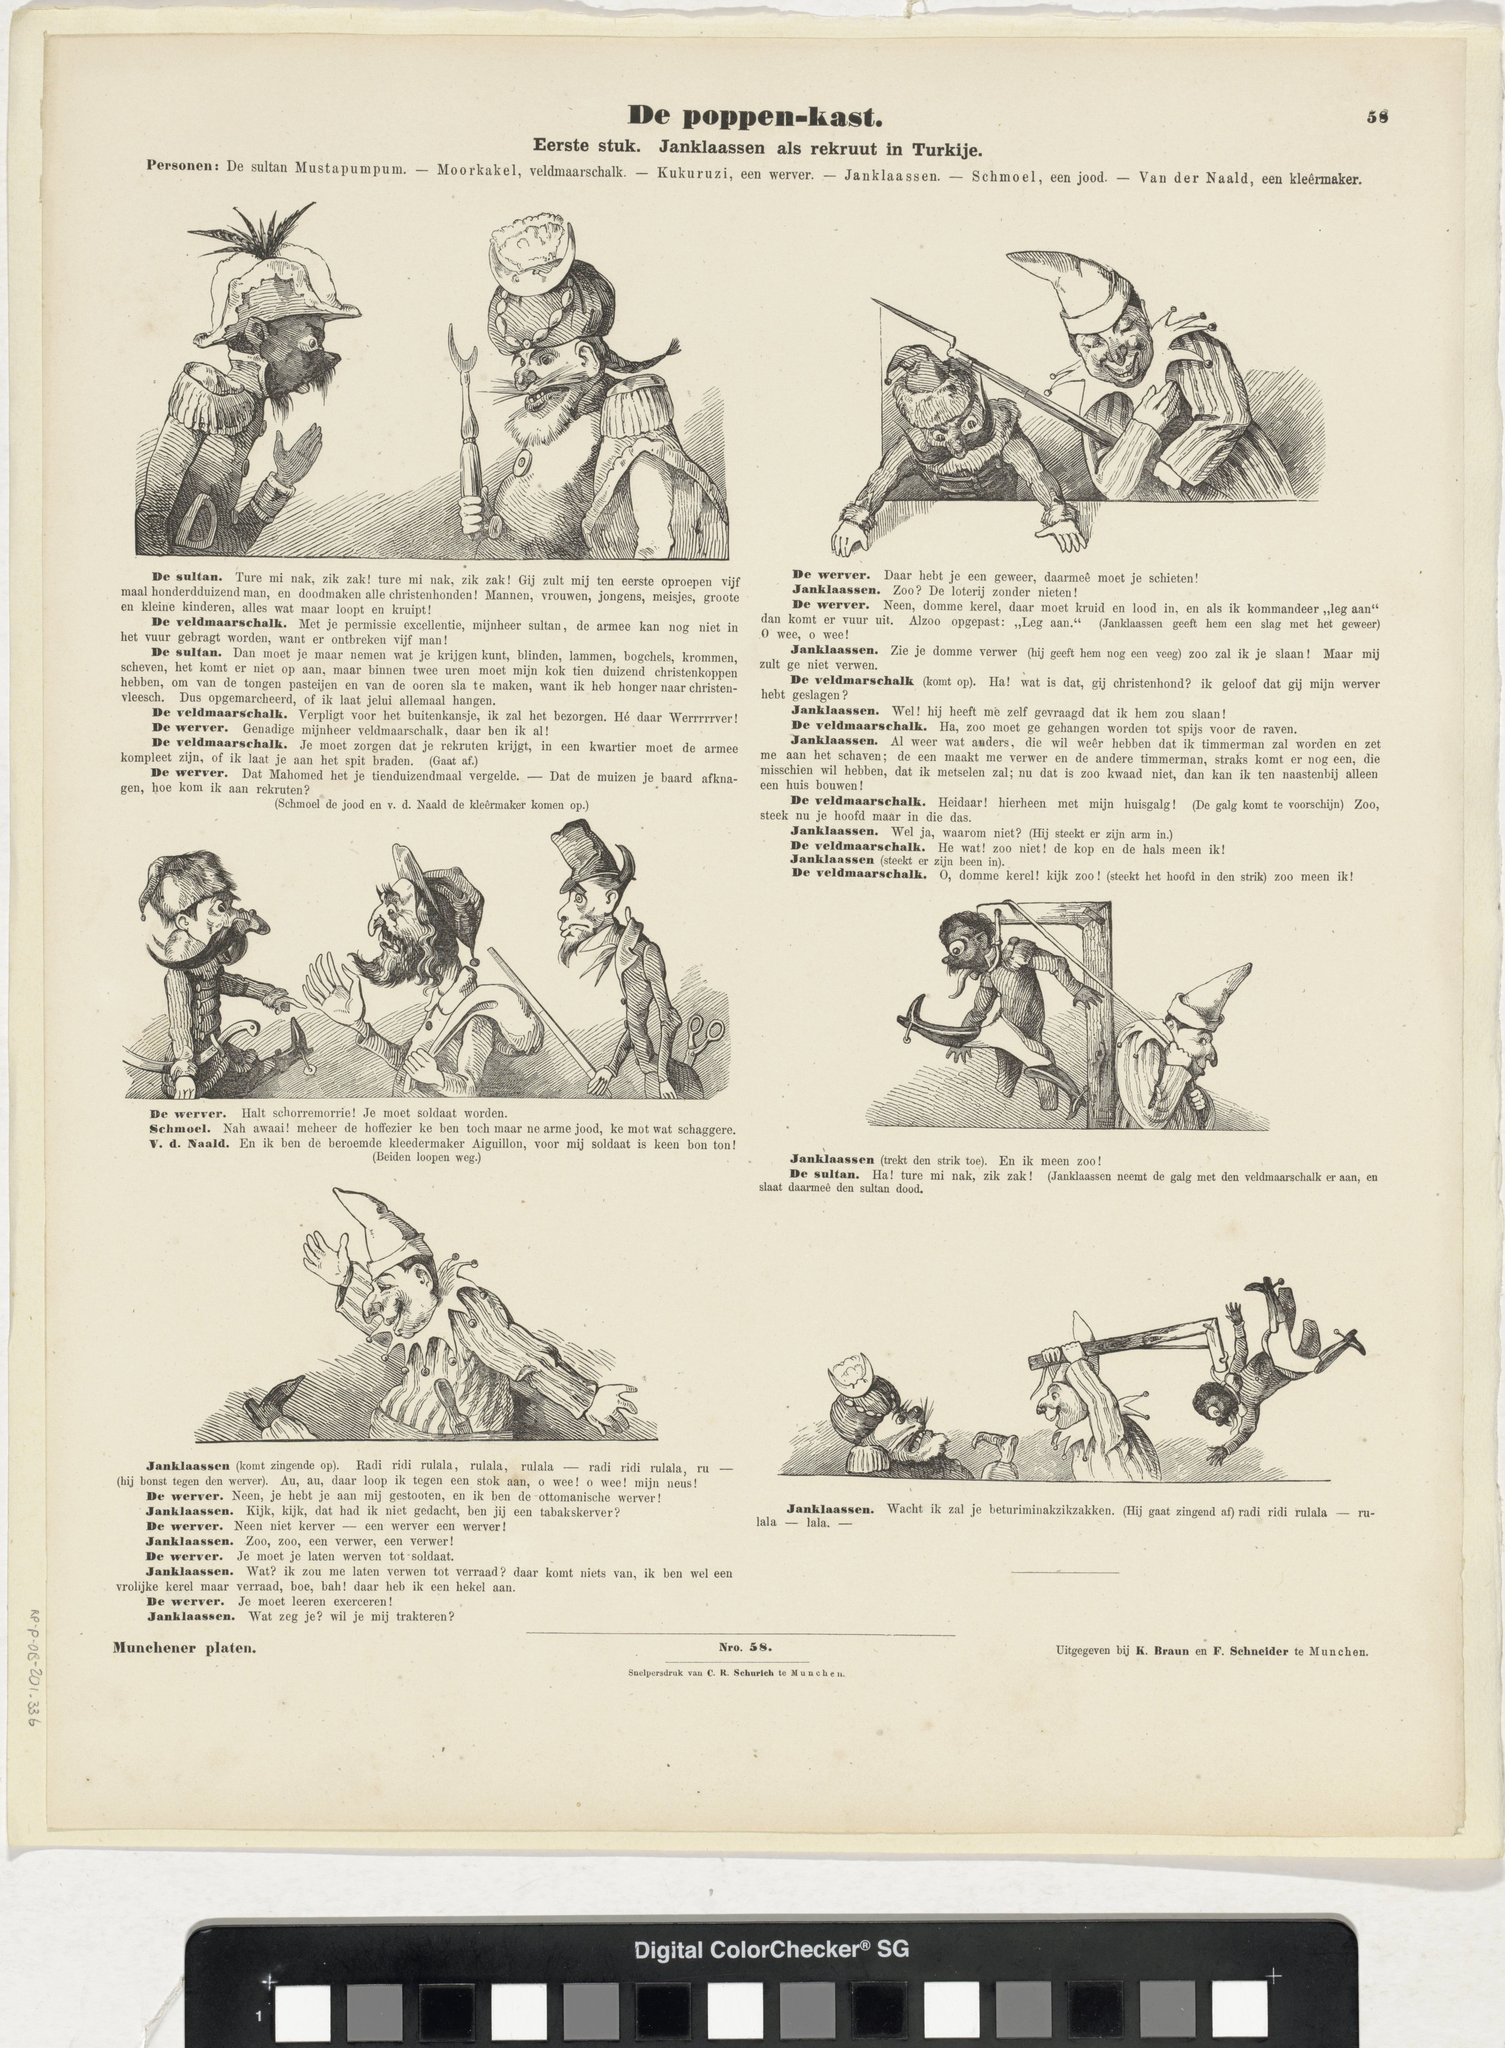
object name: print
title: Munchener platen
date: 1843-1920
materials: paper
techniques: letterpress printing, engraving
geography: munich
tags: puppet, punch and judy, puppet and marionette show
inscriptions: collector's mark: Lugt 2760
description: Blad met 6 voorstellingen van poppenkastpoppen. Onder de afbeeldingen tekst voor een poppenkastvoorstelling. Genummerd midden onder: Nro. 58. Genummerd rechtsboven: 58.